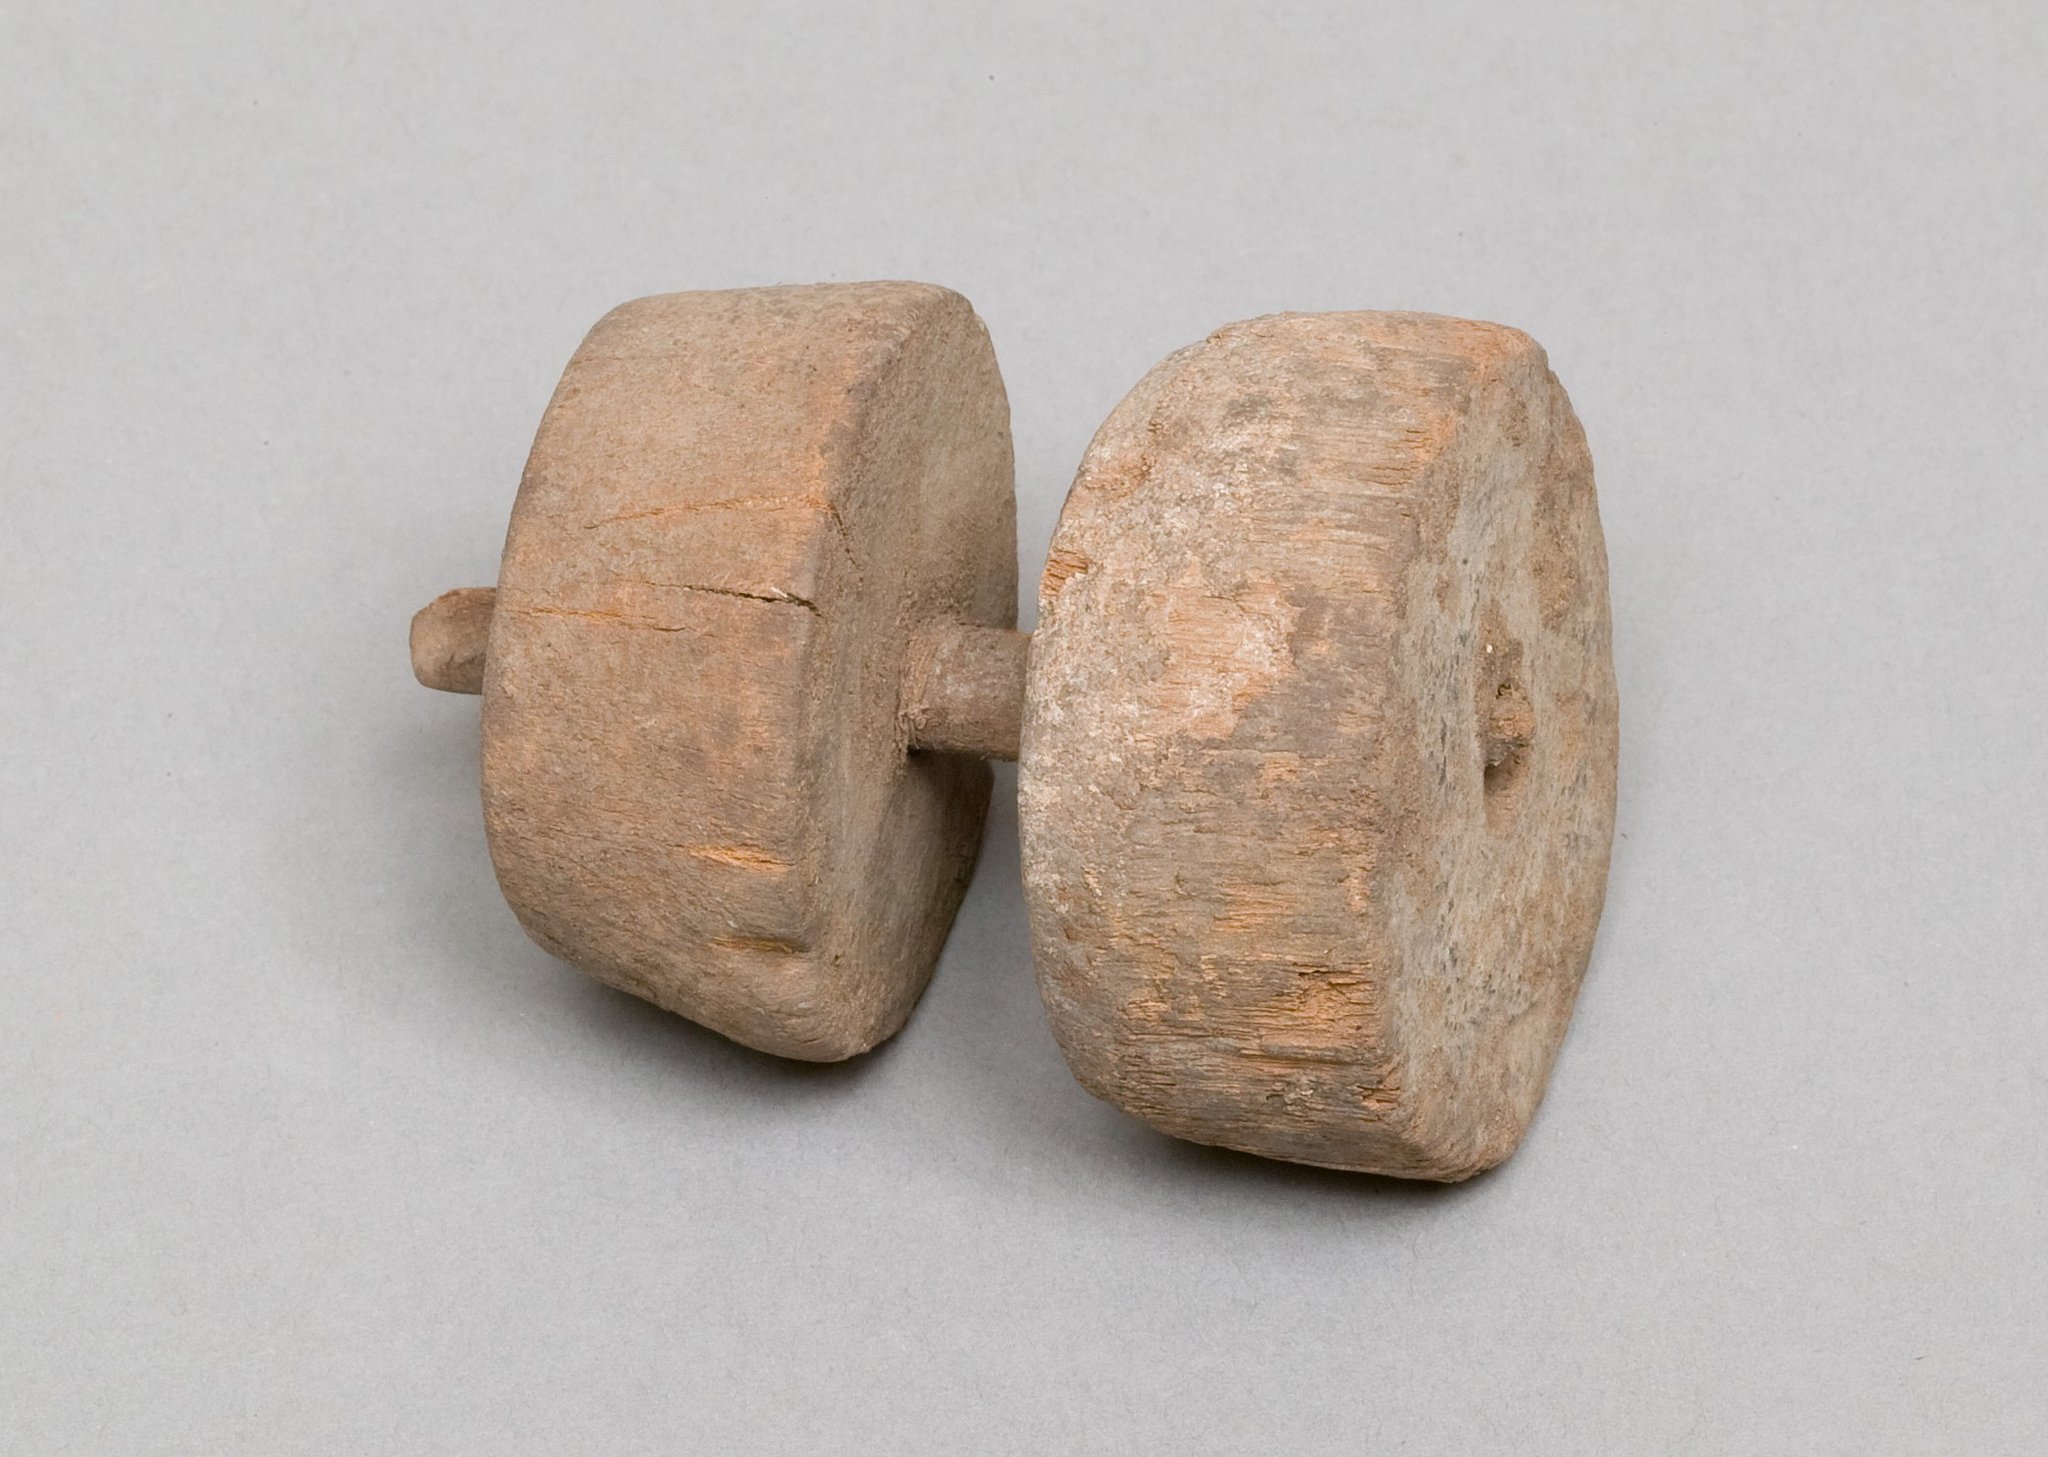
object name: spindle whorl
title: Spindle with 2 whorls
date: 1295-1070 BCE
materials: wood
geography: egypt